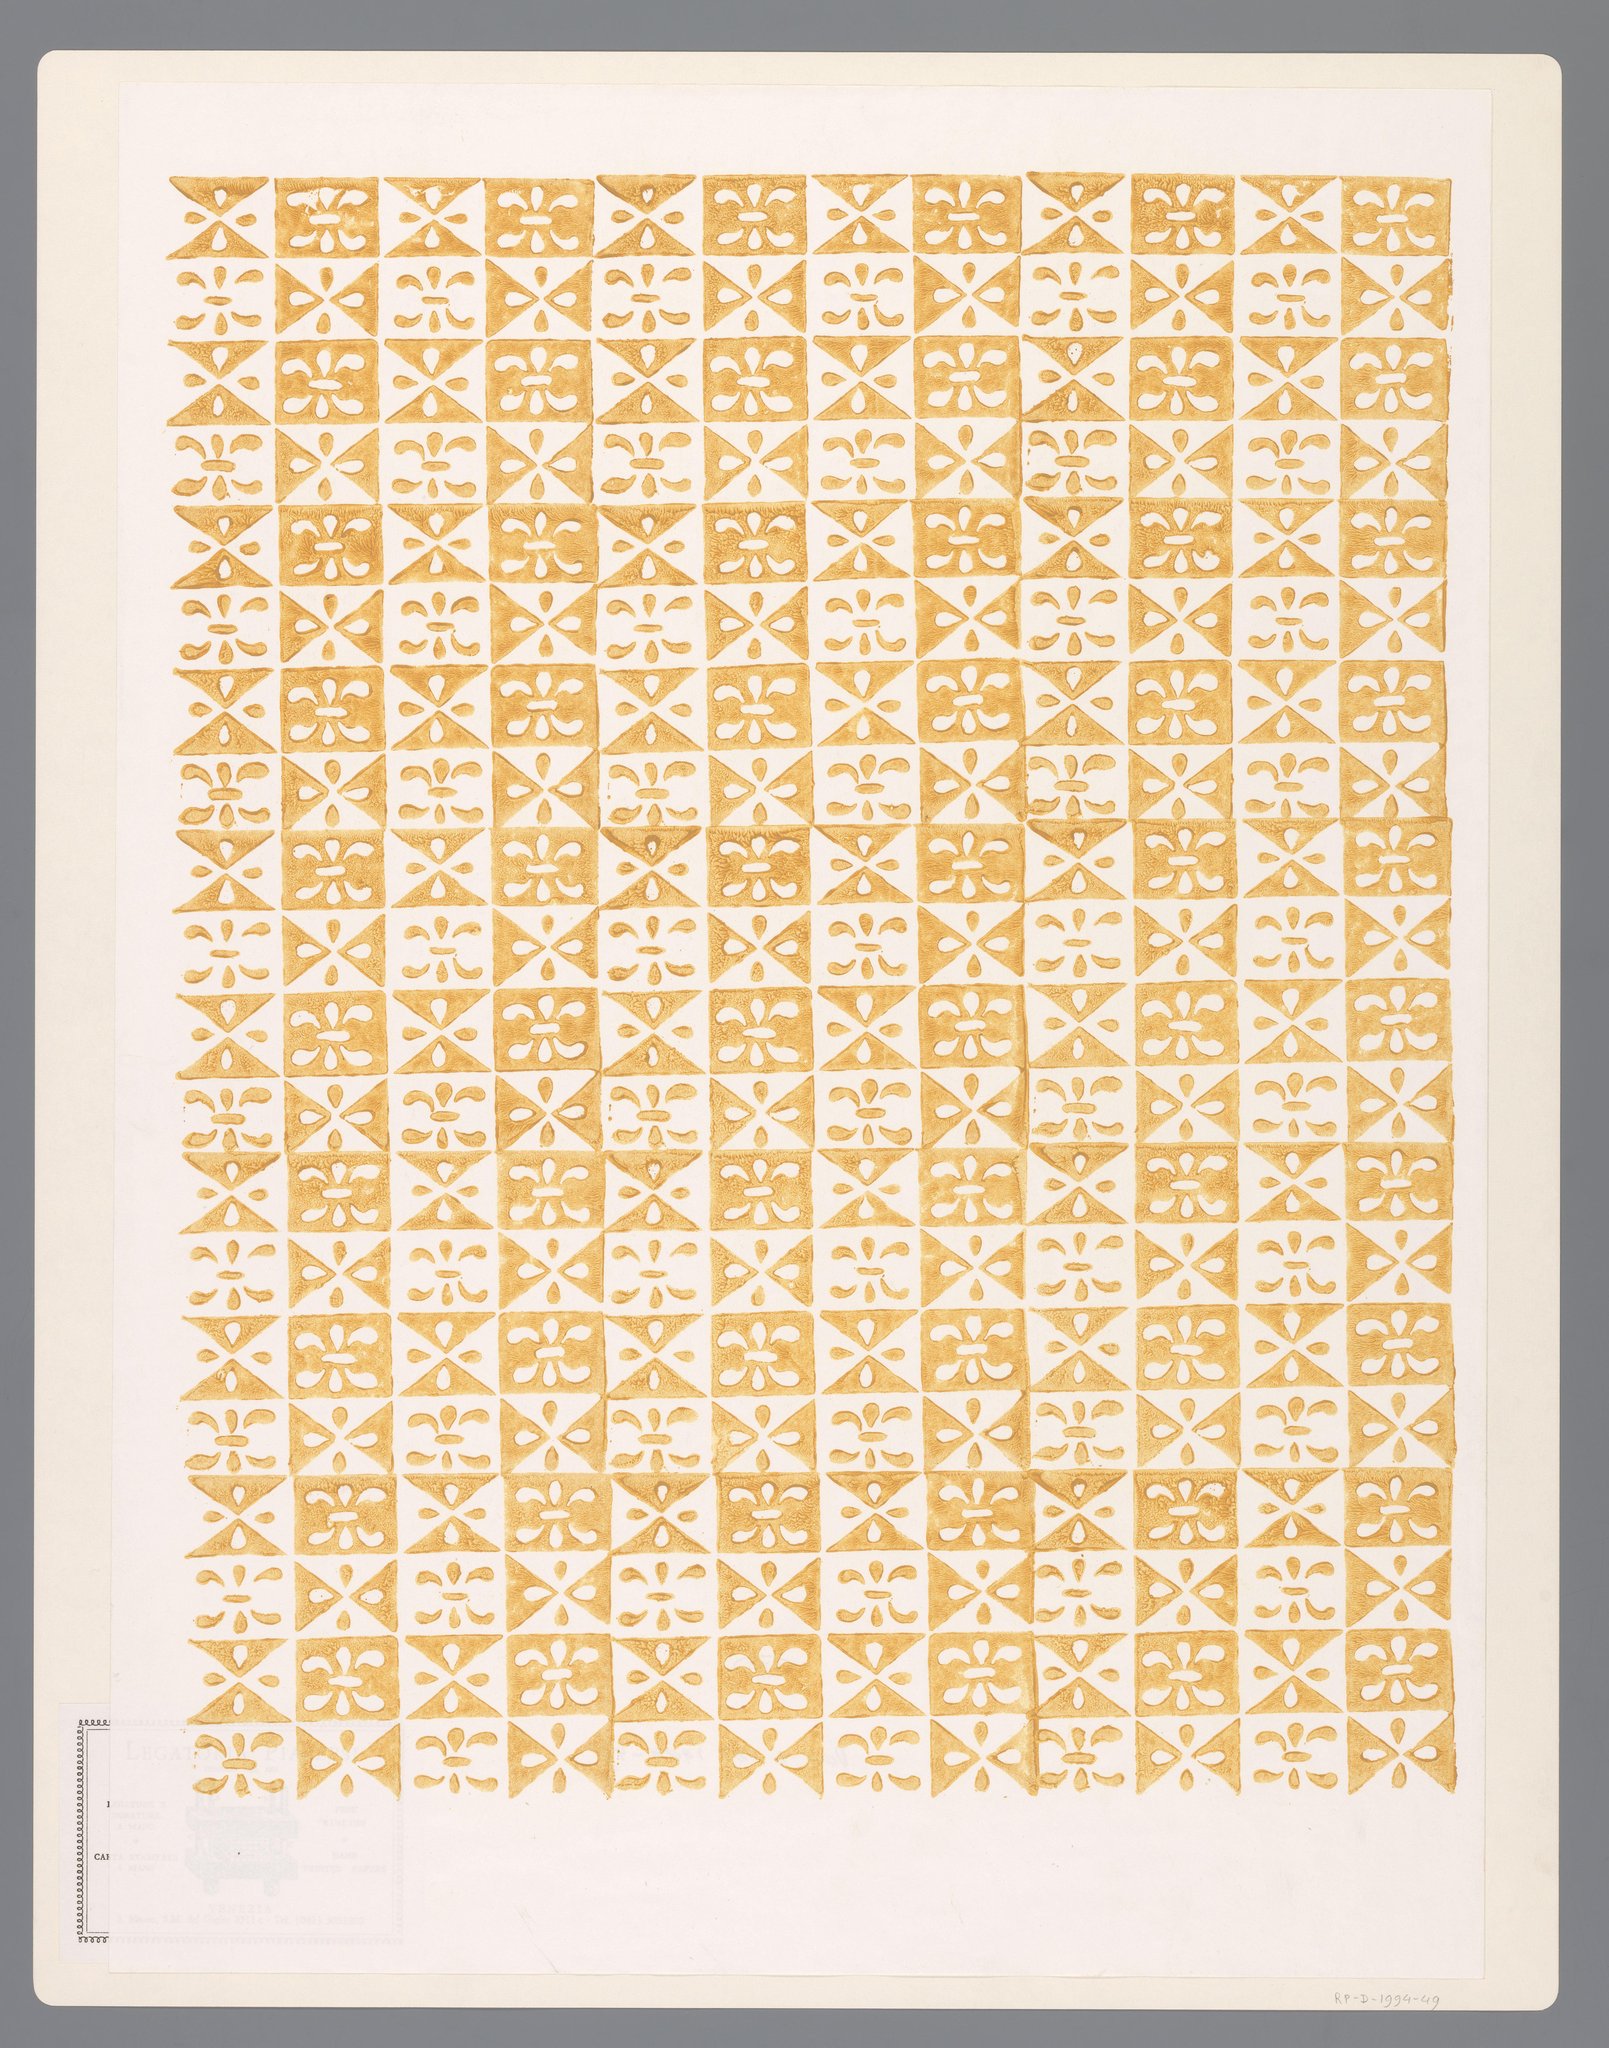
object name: printed paper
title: Blad met schaakbordpatroon van blokjes met ornamenten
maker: legatoria piazzesi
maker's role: printer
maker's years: 1905-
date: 1990-1994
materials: paper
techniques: printing block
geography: venice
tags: ornament derived from plant forms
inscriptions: collector's mark: Lugt 2228